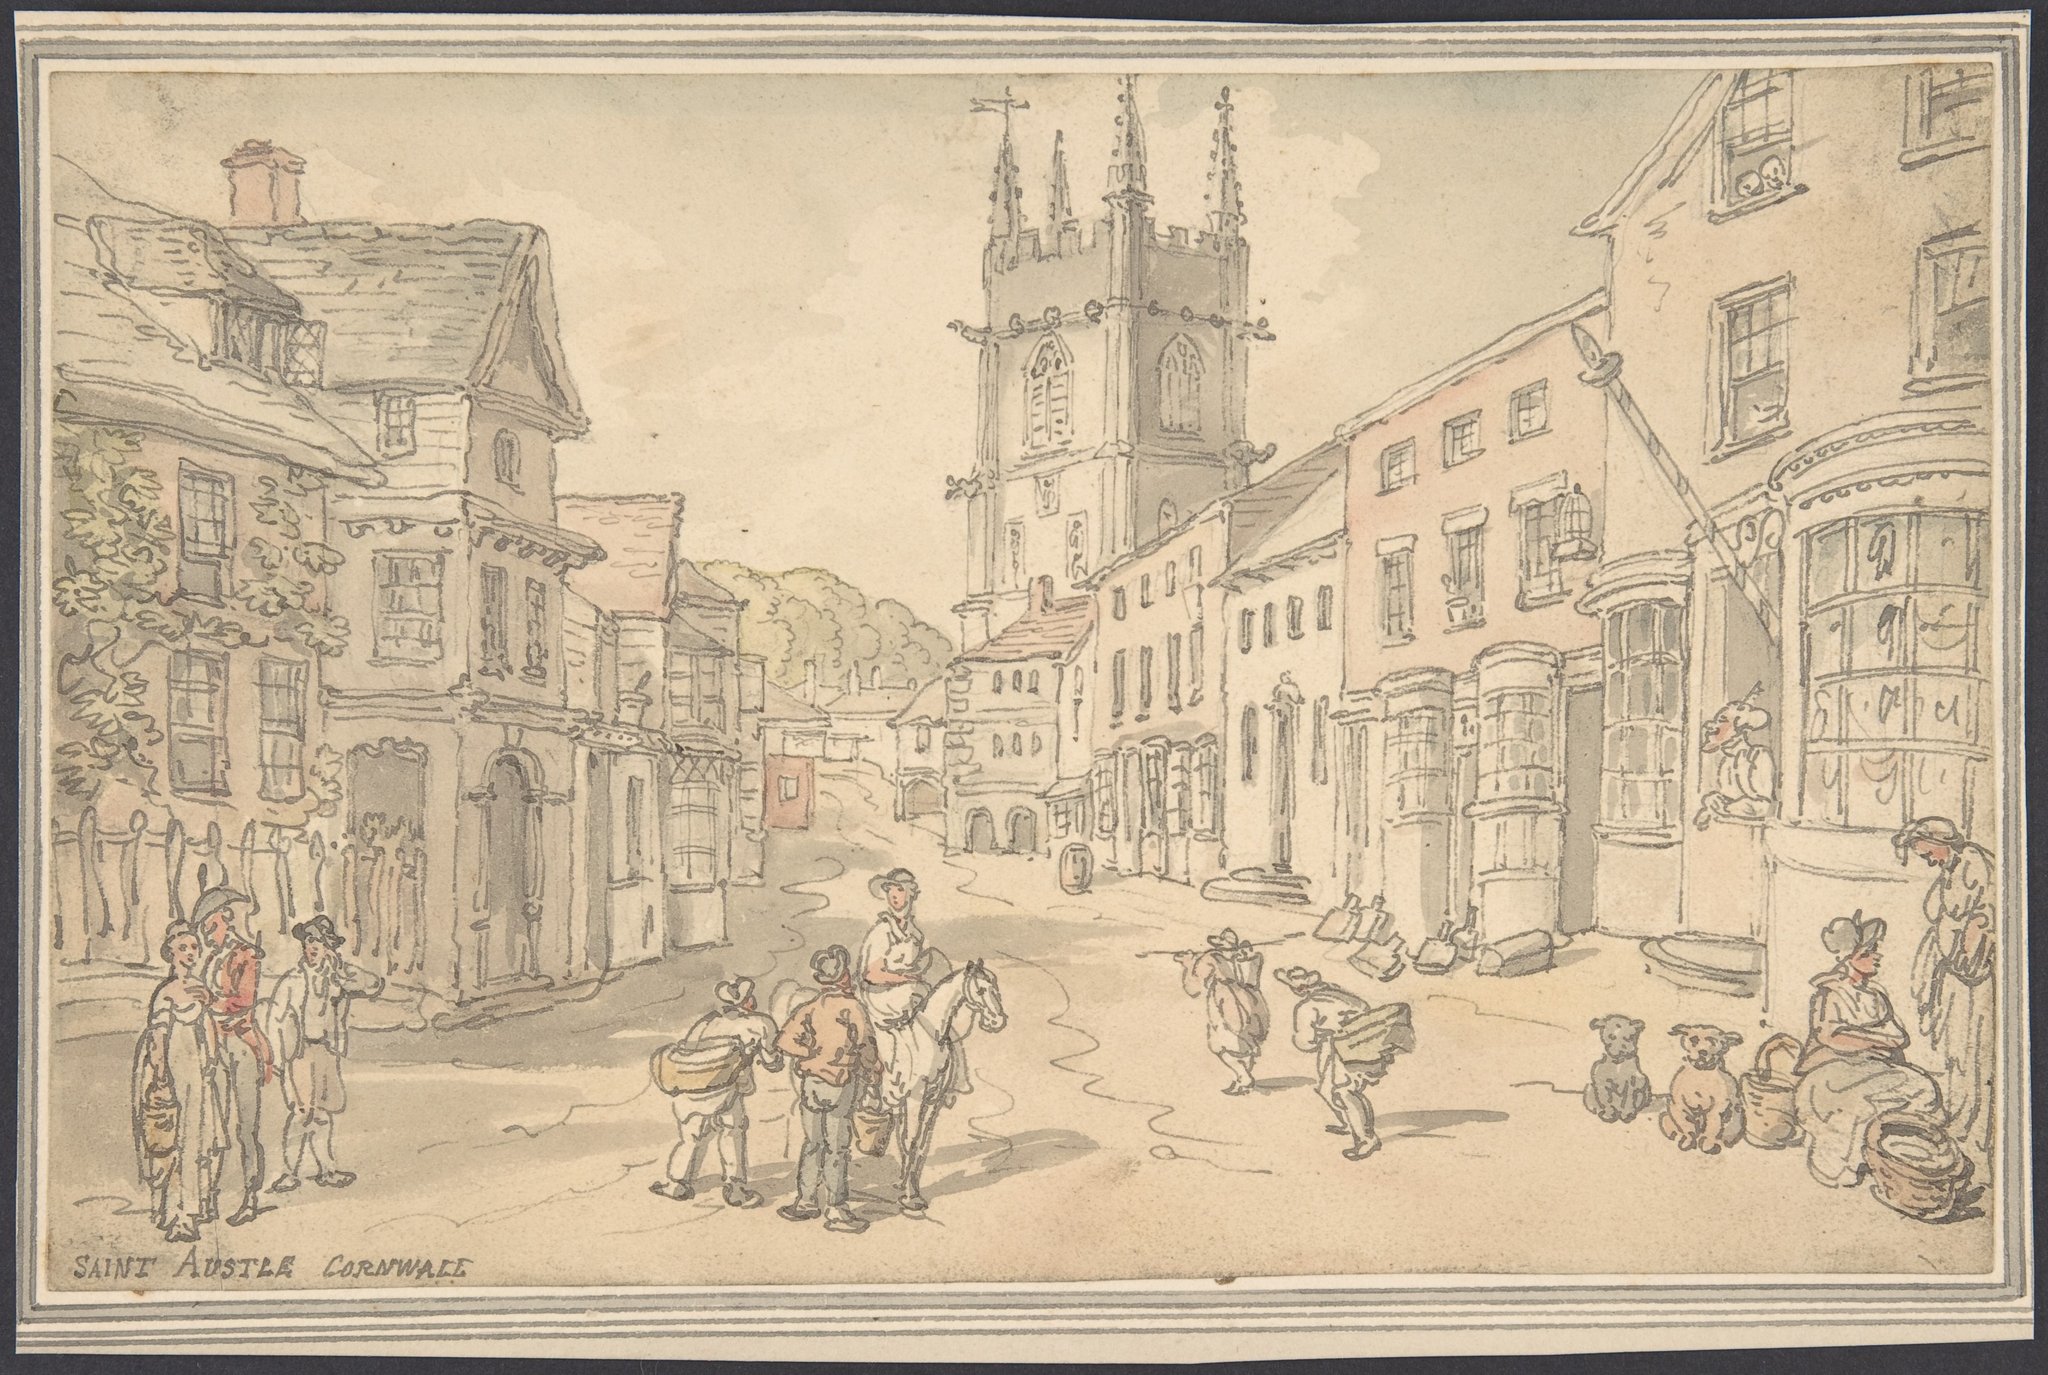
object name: drawing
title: St. Austle, Cornwall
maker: thomas rowlandson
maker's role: artist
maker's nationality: british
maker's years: 1757-1827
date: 1780-1827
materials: graphite, ink, watercolor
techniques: pen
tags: human figures,buildings,streets,dogs,horses